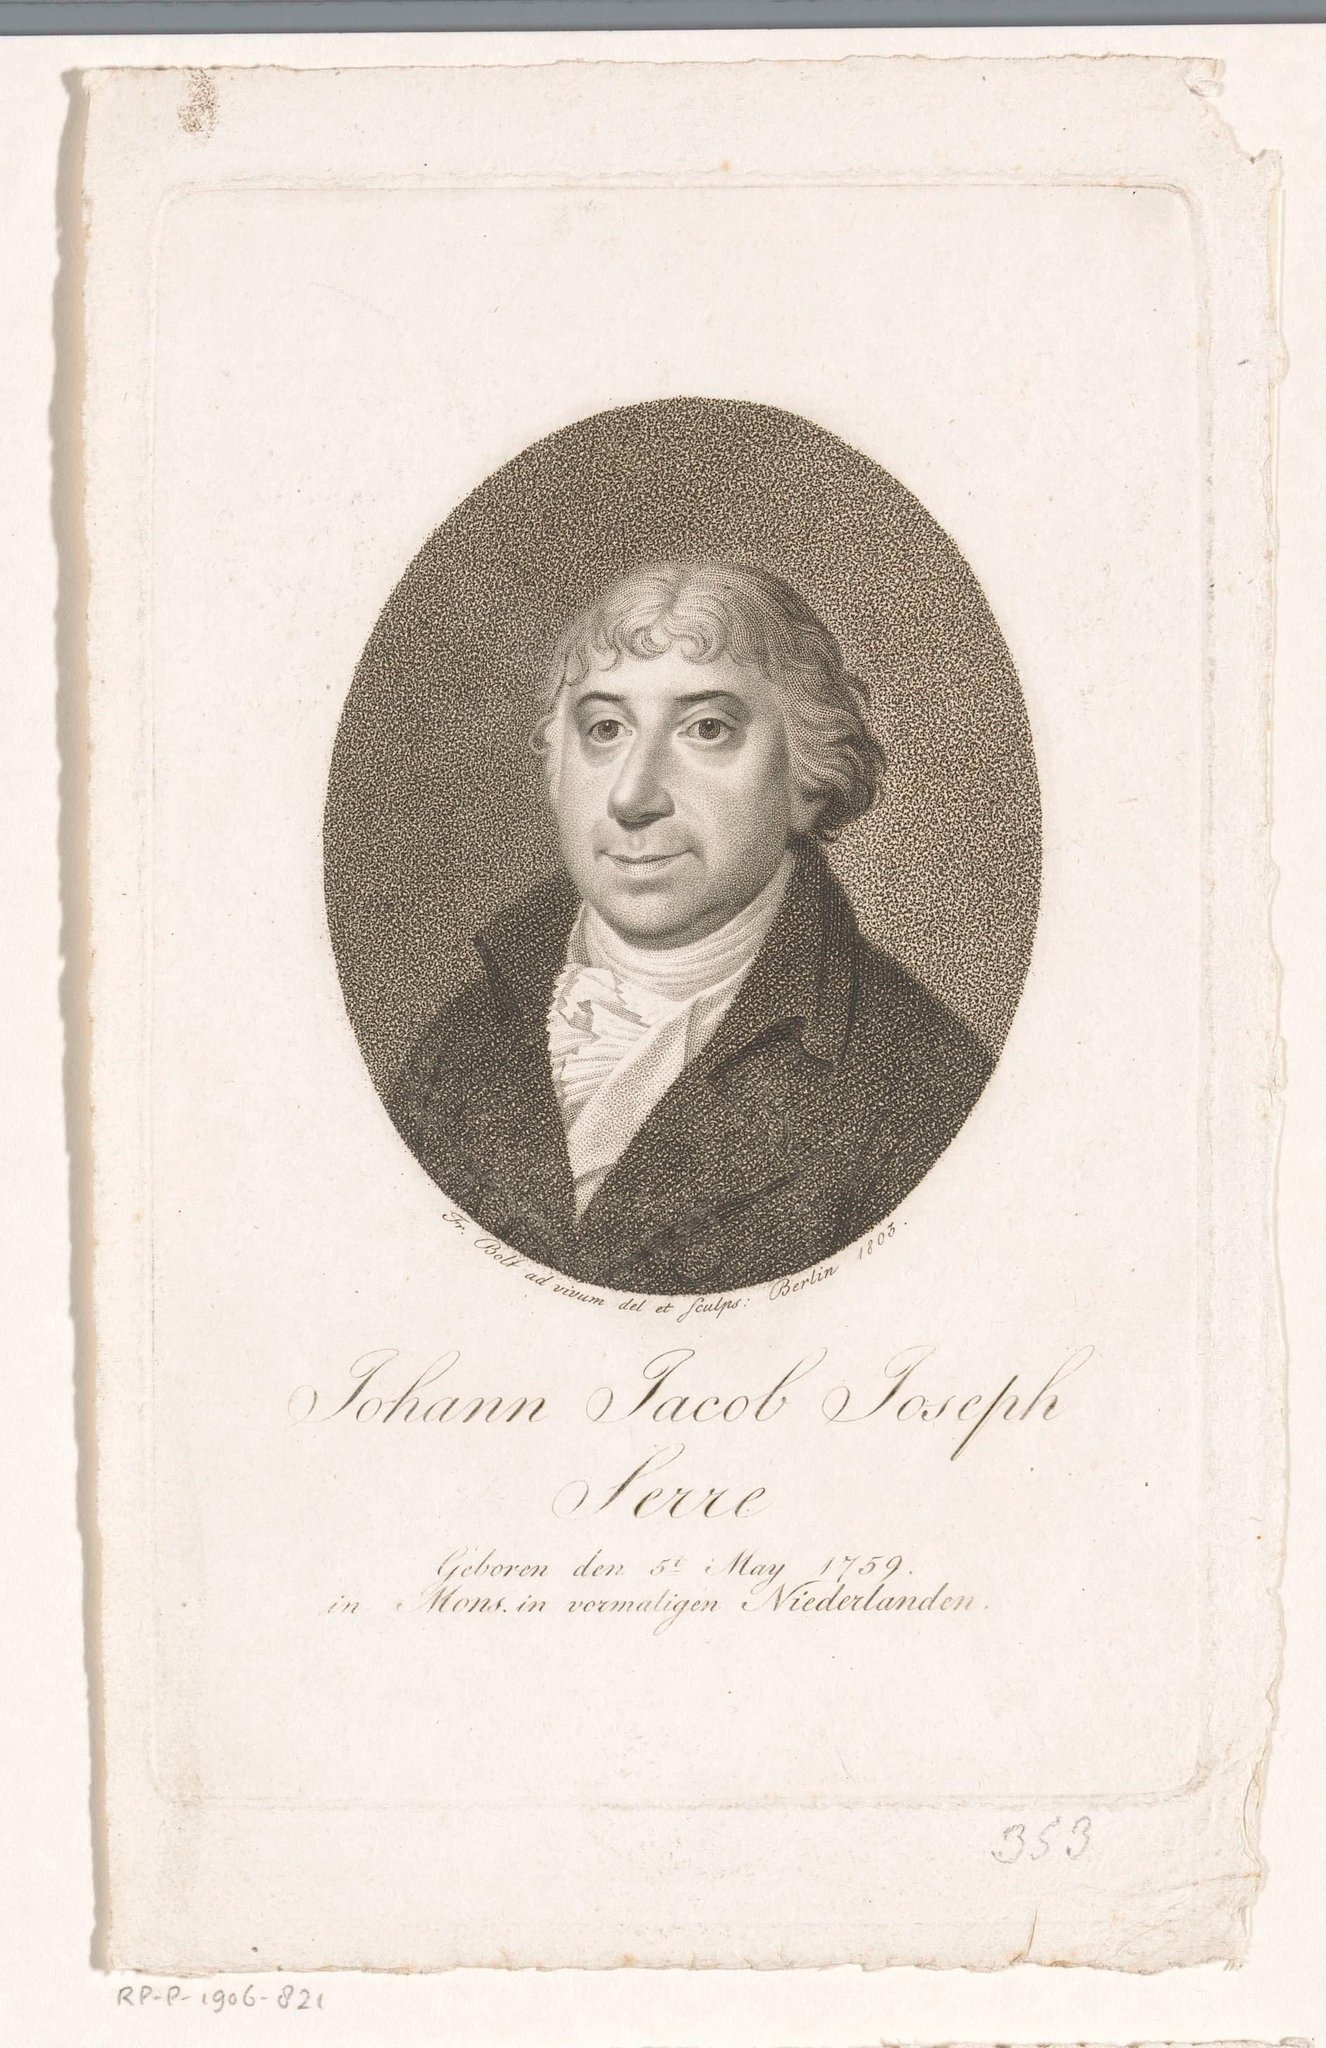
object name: print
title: Portret van Johann Jacob Joseph Serre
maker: johann friedrich bolt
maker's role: print maker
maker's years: 1769-1836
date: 1803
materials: paper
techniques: stippling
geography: berlin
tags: historical persons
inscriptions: collector's mark: Lugt 2228